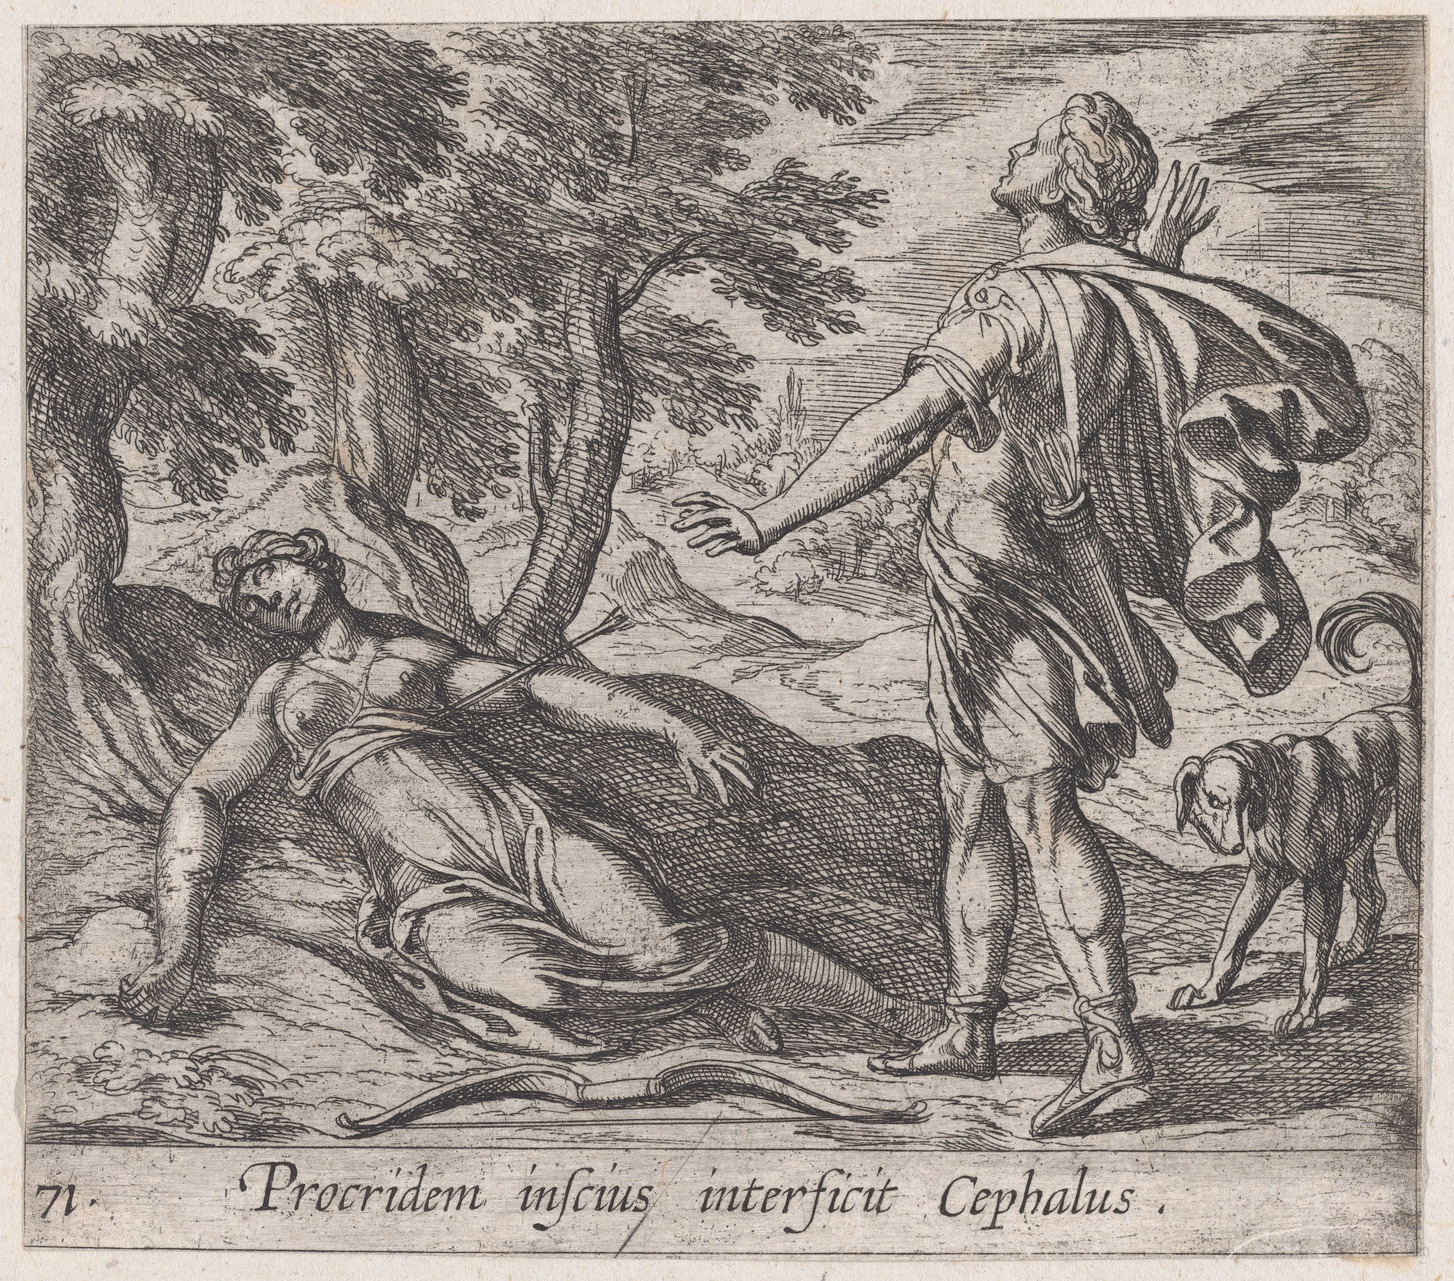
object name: print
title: Plate 71: Procris Killed by Cephalus's Javelin (Procridem inscius interficit Cephalus), from Ovid's 'Metamorphoses'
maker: antonio tempesta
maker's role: artist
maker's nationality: italian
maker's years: 1555-1630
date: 1606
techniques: etching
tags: men,female nudes,dogs